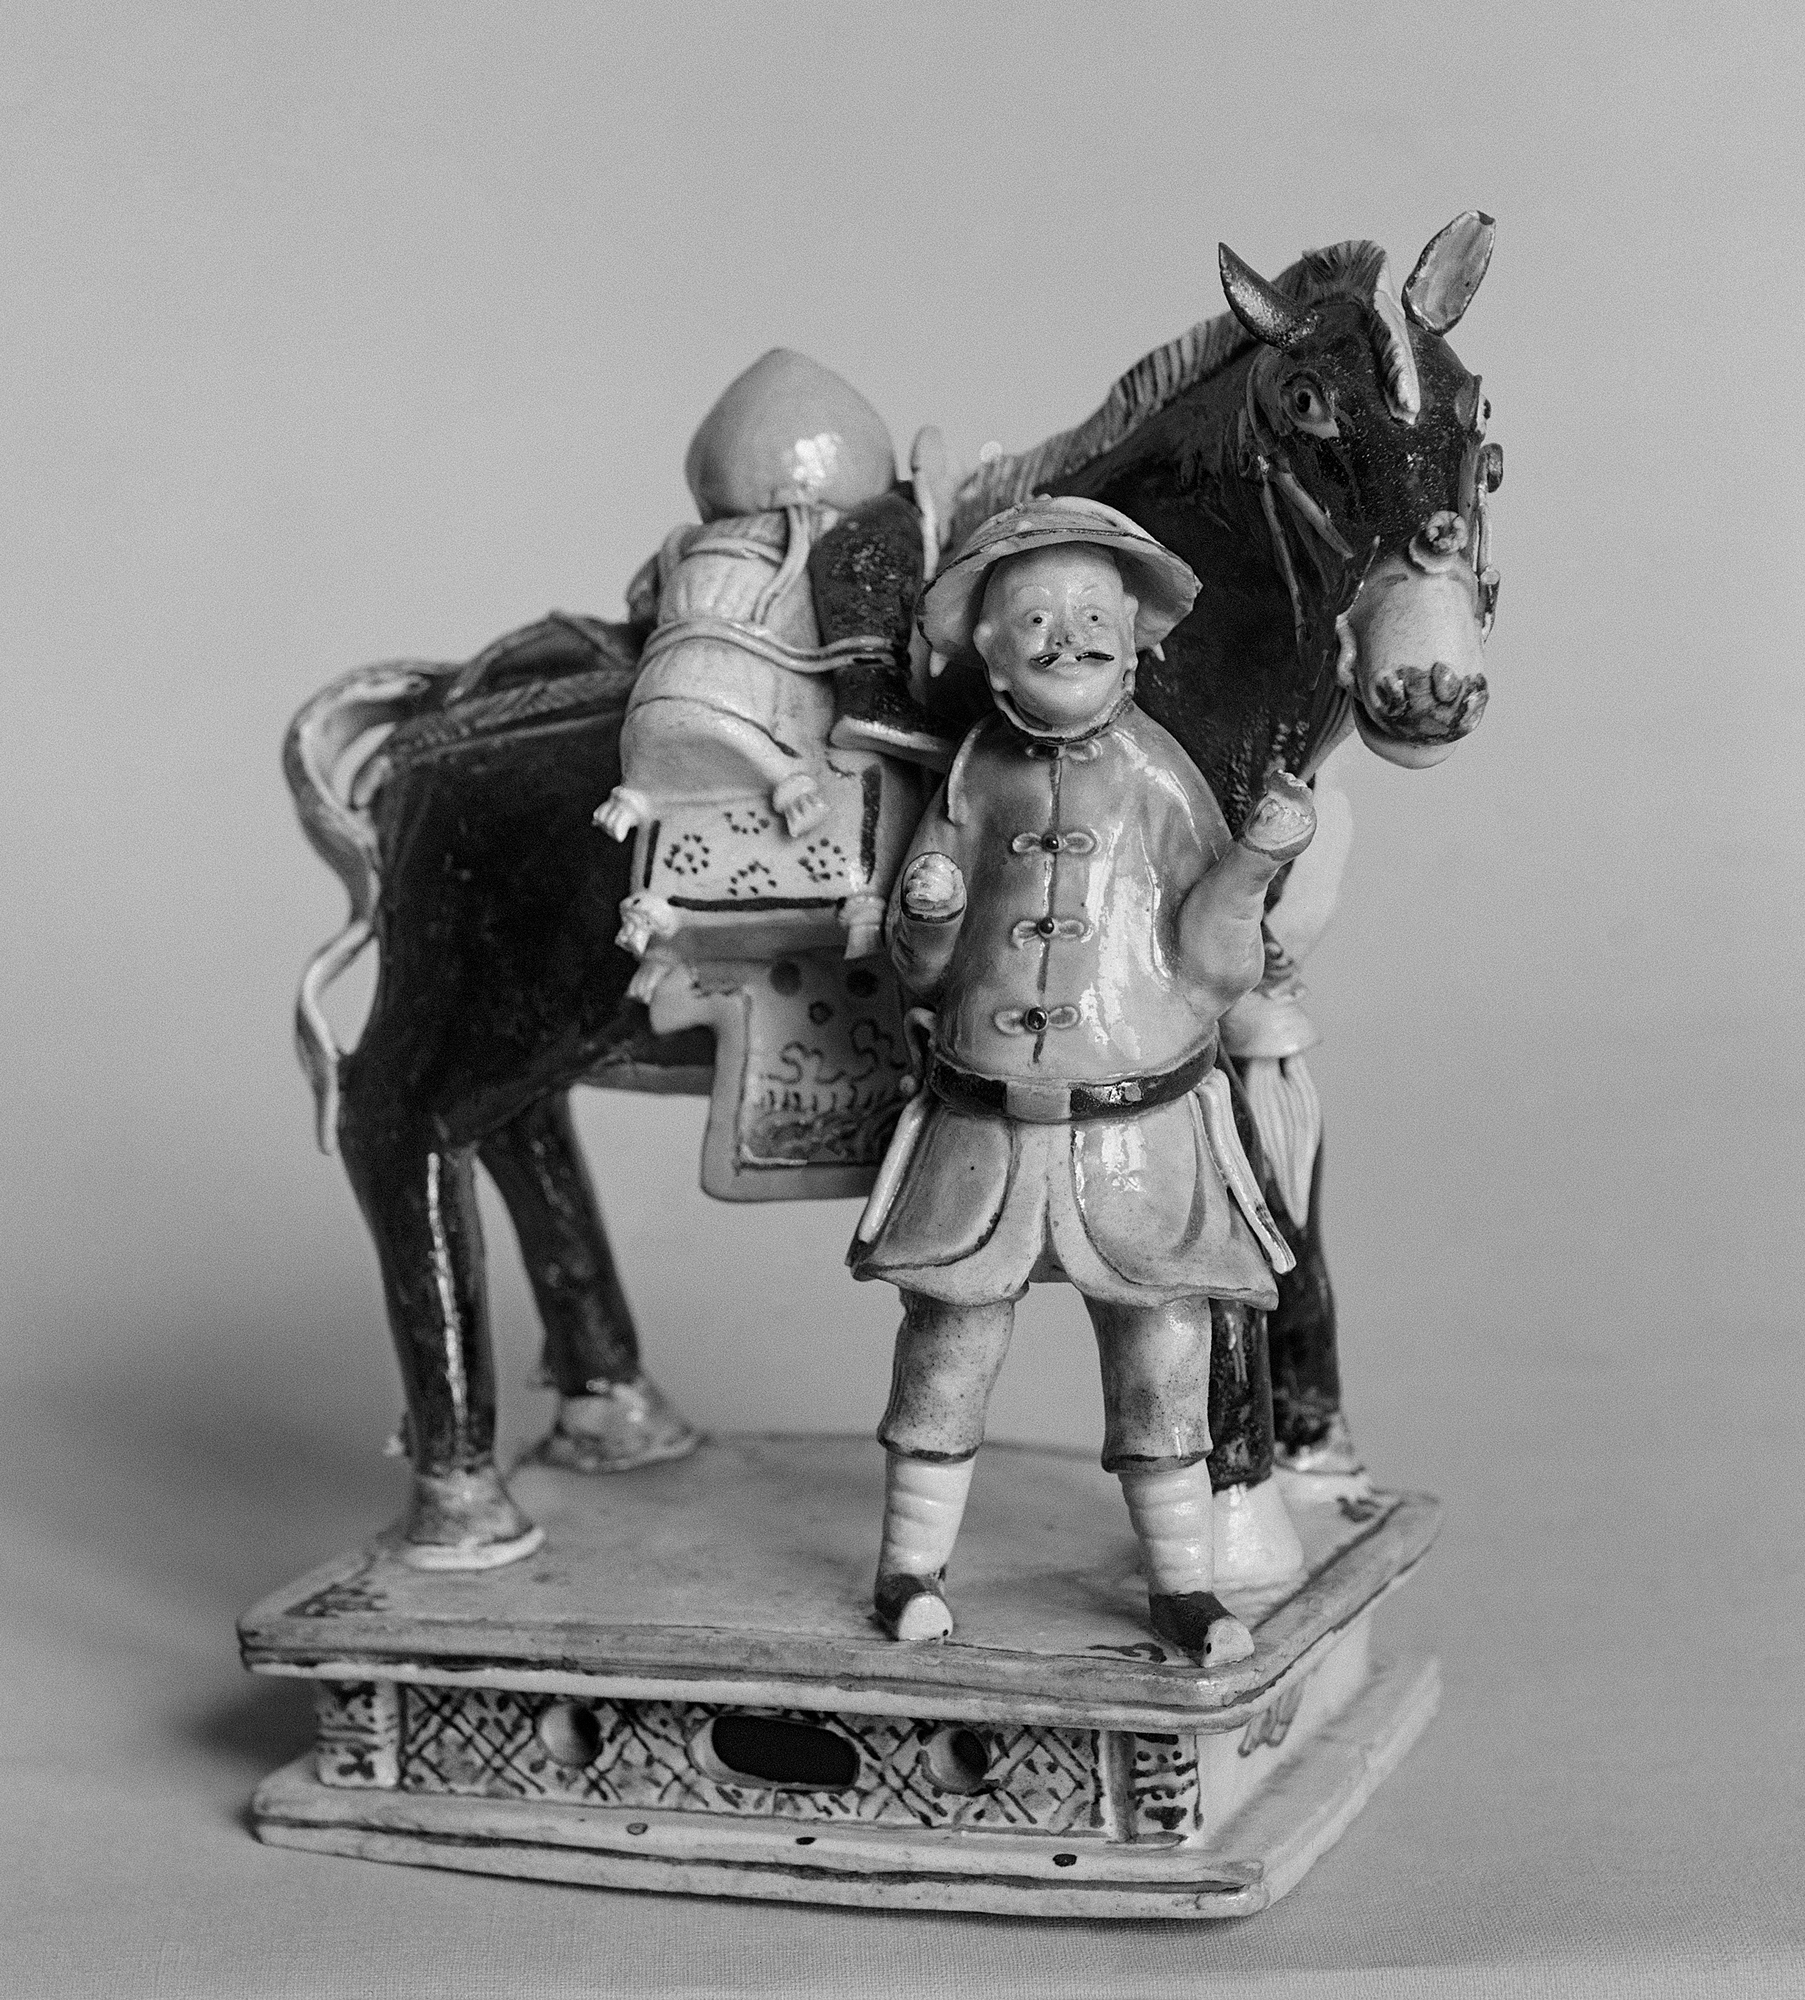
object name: figure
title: Figure of a Pack of Horse and Attendant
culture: chinese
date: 1736-1795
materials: porcelain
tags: men,horses